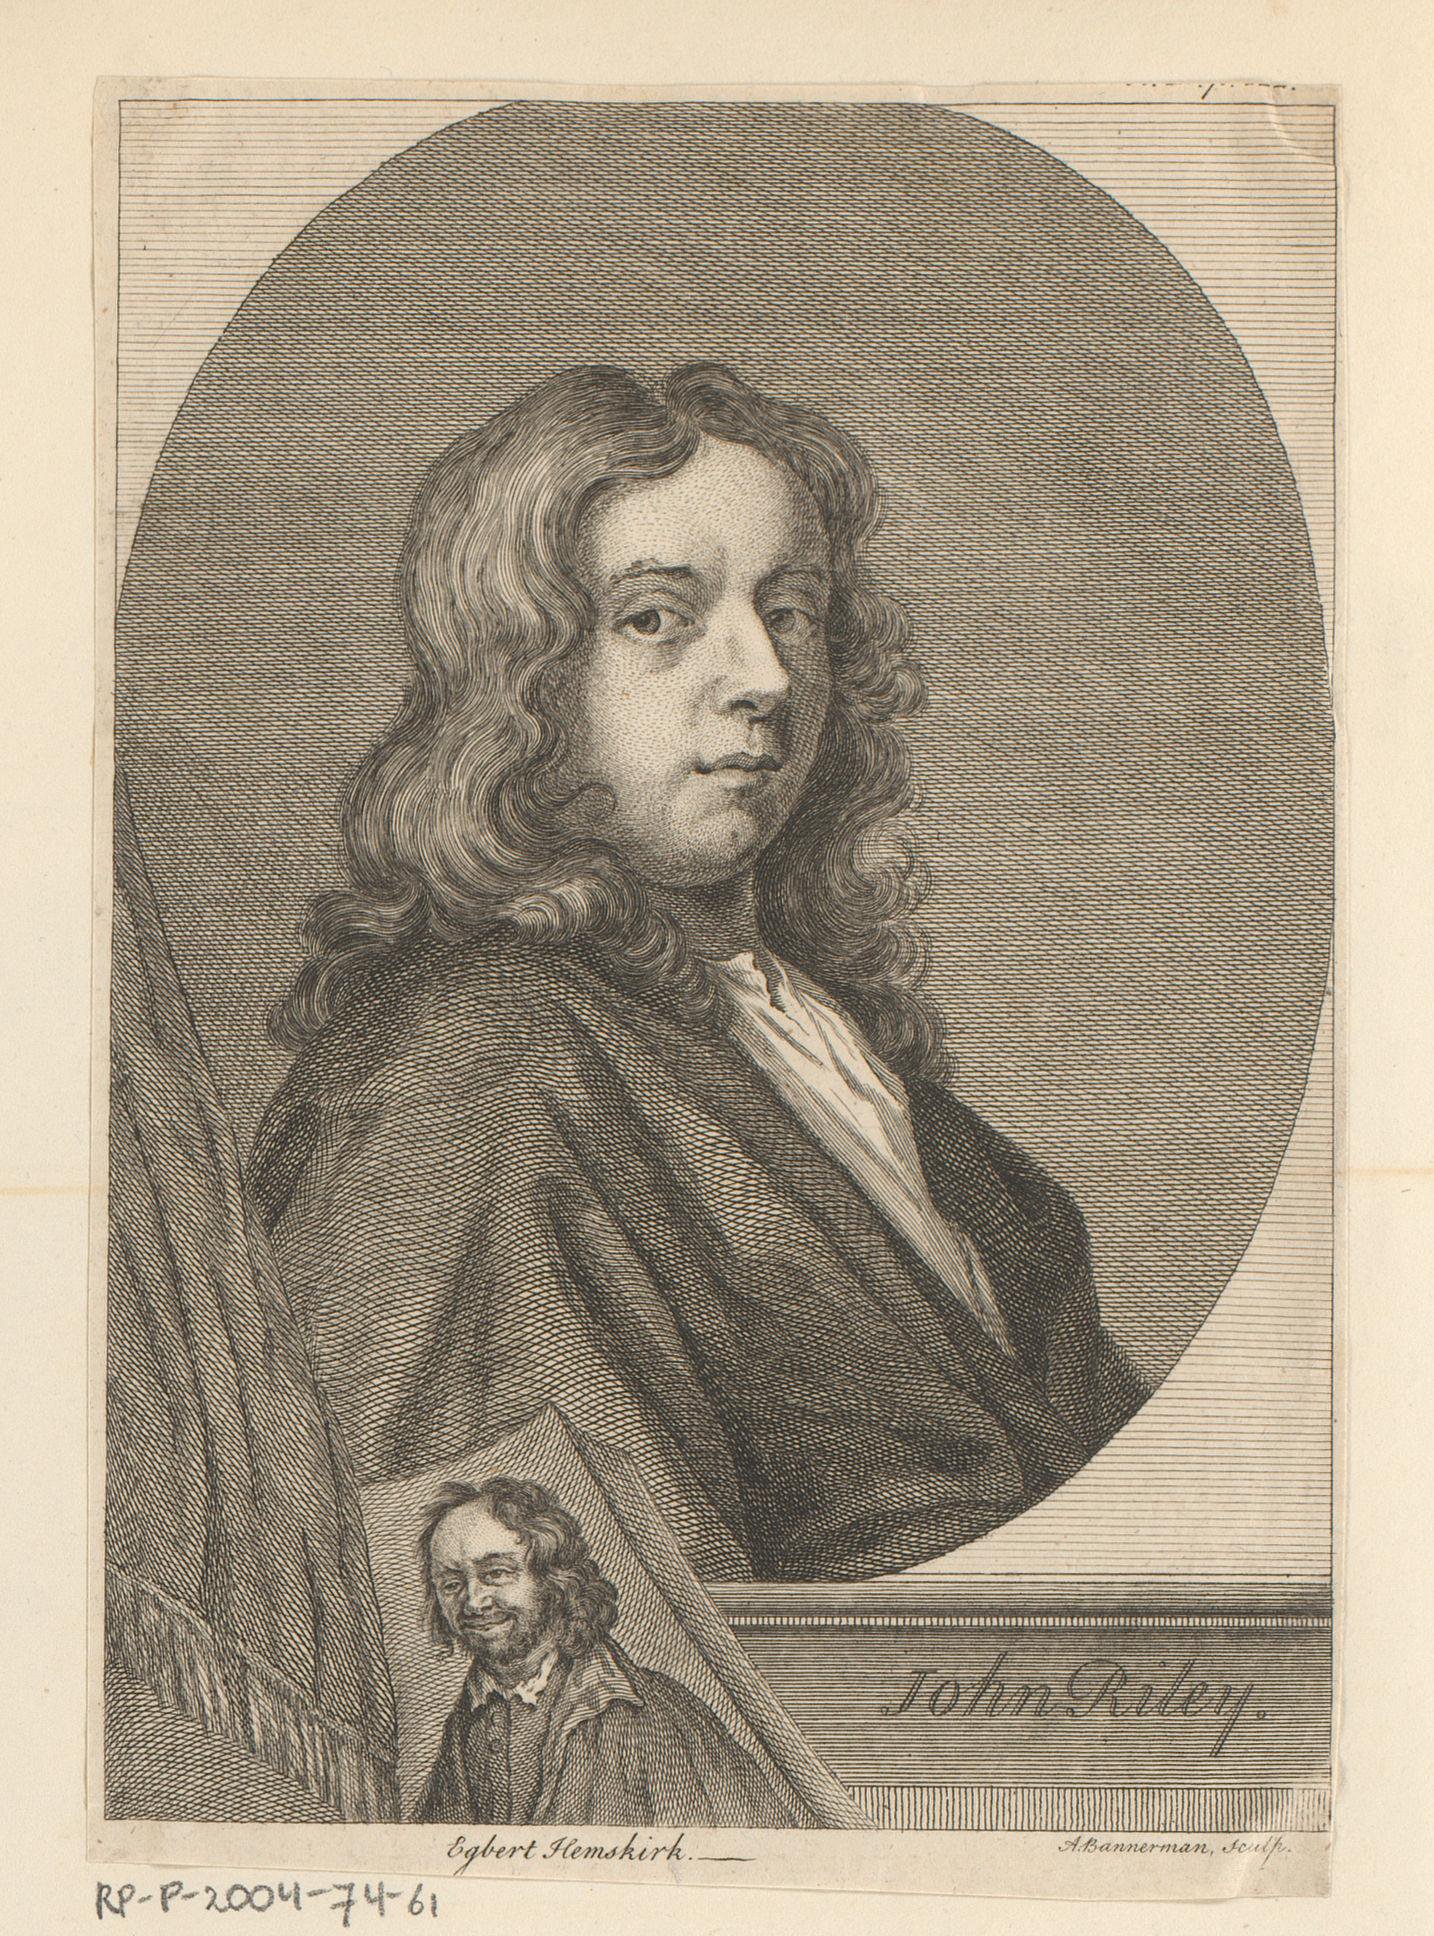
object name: album leaf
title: Portret van John Riley en Egbert van Heemskerck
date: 1762-1789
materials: paper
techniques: engraving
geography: london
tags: egbert van heemskerck (i), london, painter, john riley, historical persons, portrait, self-portrait of painter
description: Prent uit: Walpole, Horace. Anecdotes of painting in England with some account of the principal artists and incidental notes on other arts collected by the late Mr. George Vertue and now digested and published from his original Mss. by Horace Walpole. 4 dln. Londen: Horace Walpole, [1762-1789], dl. 3, p. 122. De samensteller heeft deze prent in het album geplakt als illustratie bij: Pilkington, Matthew en Johann Heinrich Füssli. A dictionary of painters, from the revival of the art to the present period. 4 dln. Londen: John Crowder, 1805, dl. 3, p. 454.